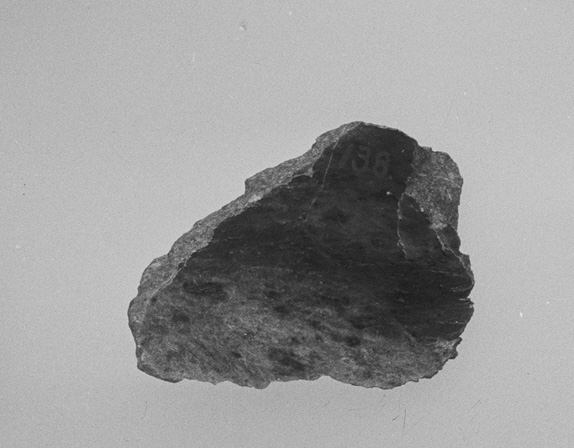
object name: fragment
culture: german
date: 1902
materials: jade